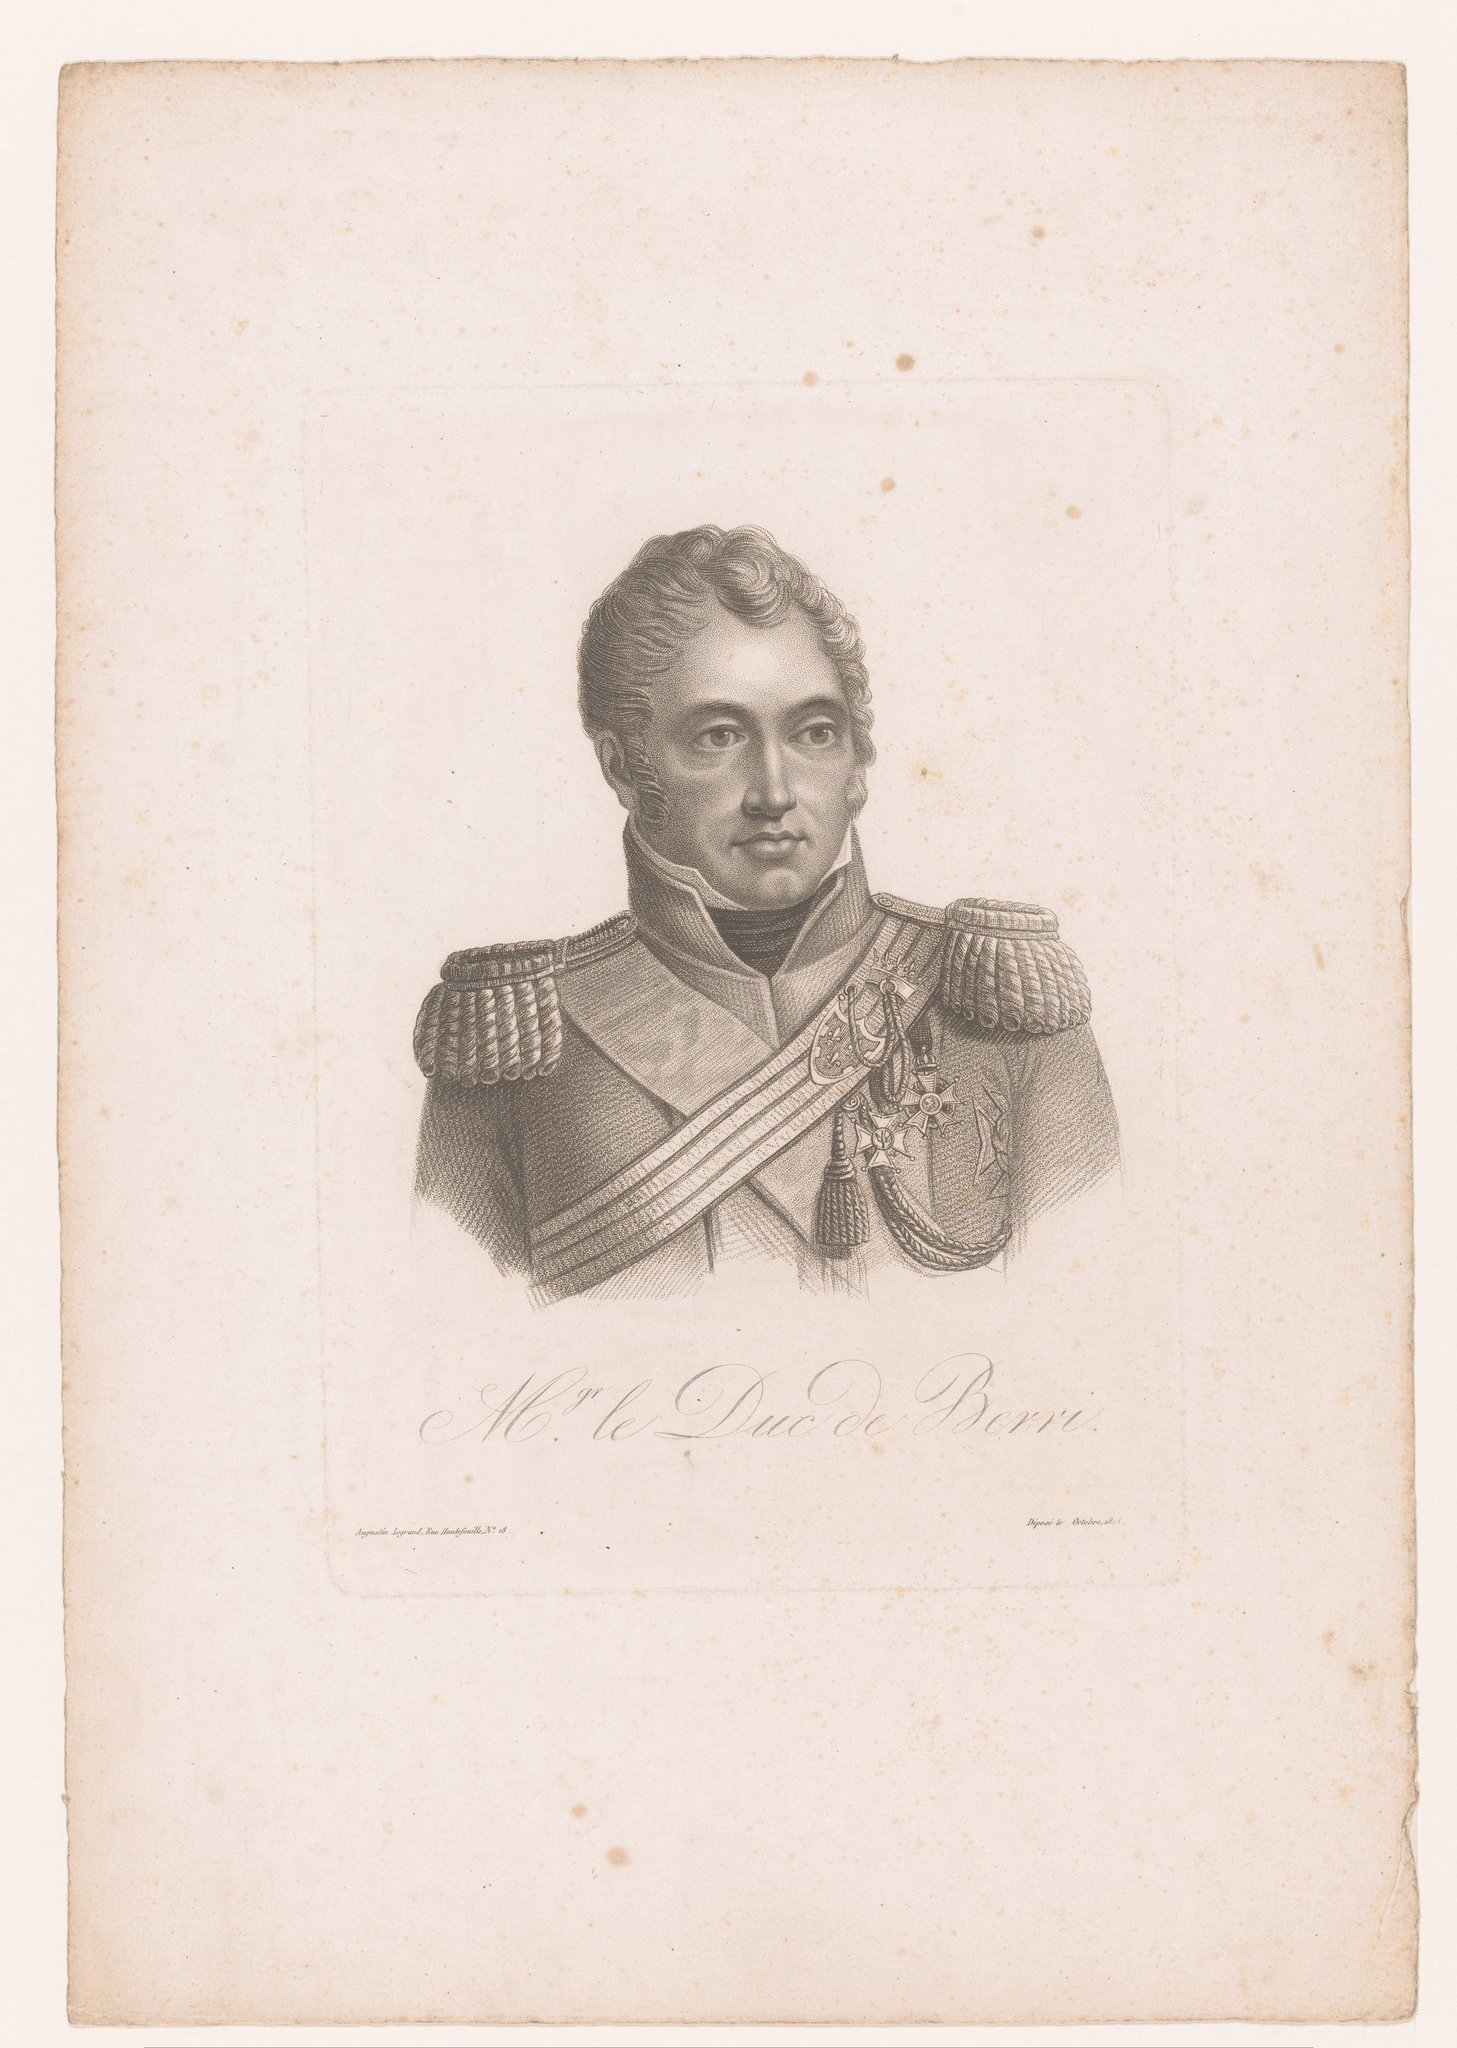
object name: print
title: Mgr. le Duc de Berri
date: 1815-1817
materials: paper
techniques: engraving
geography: france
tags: hertog van berry, historical persons, nobility and patriciate; chivalry, knighthood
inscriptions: : ‘Déposé le Octobre 1815.’, collector's mark: Lugt 2228